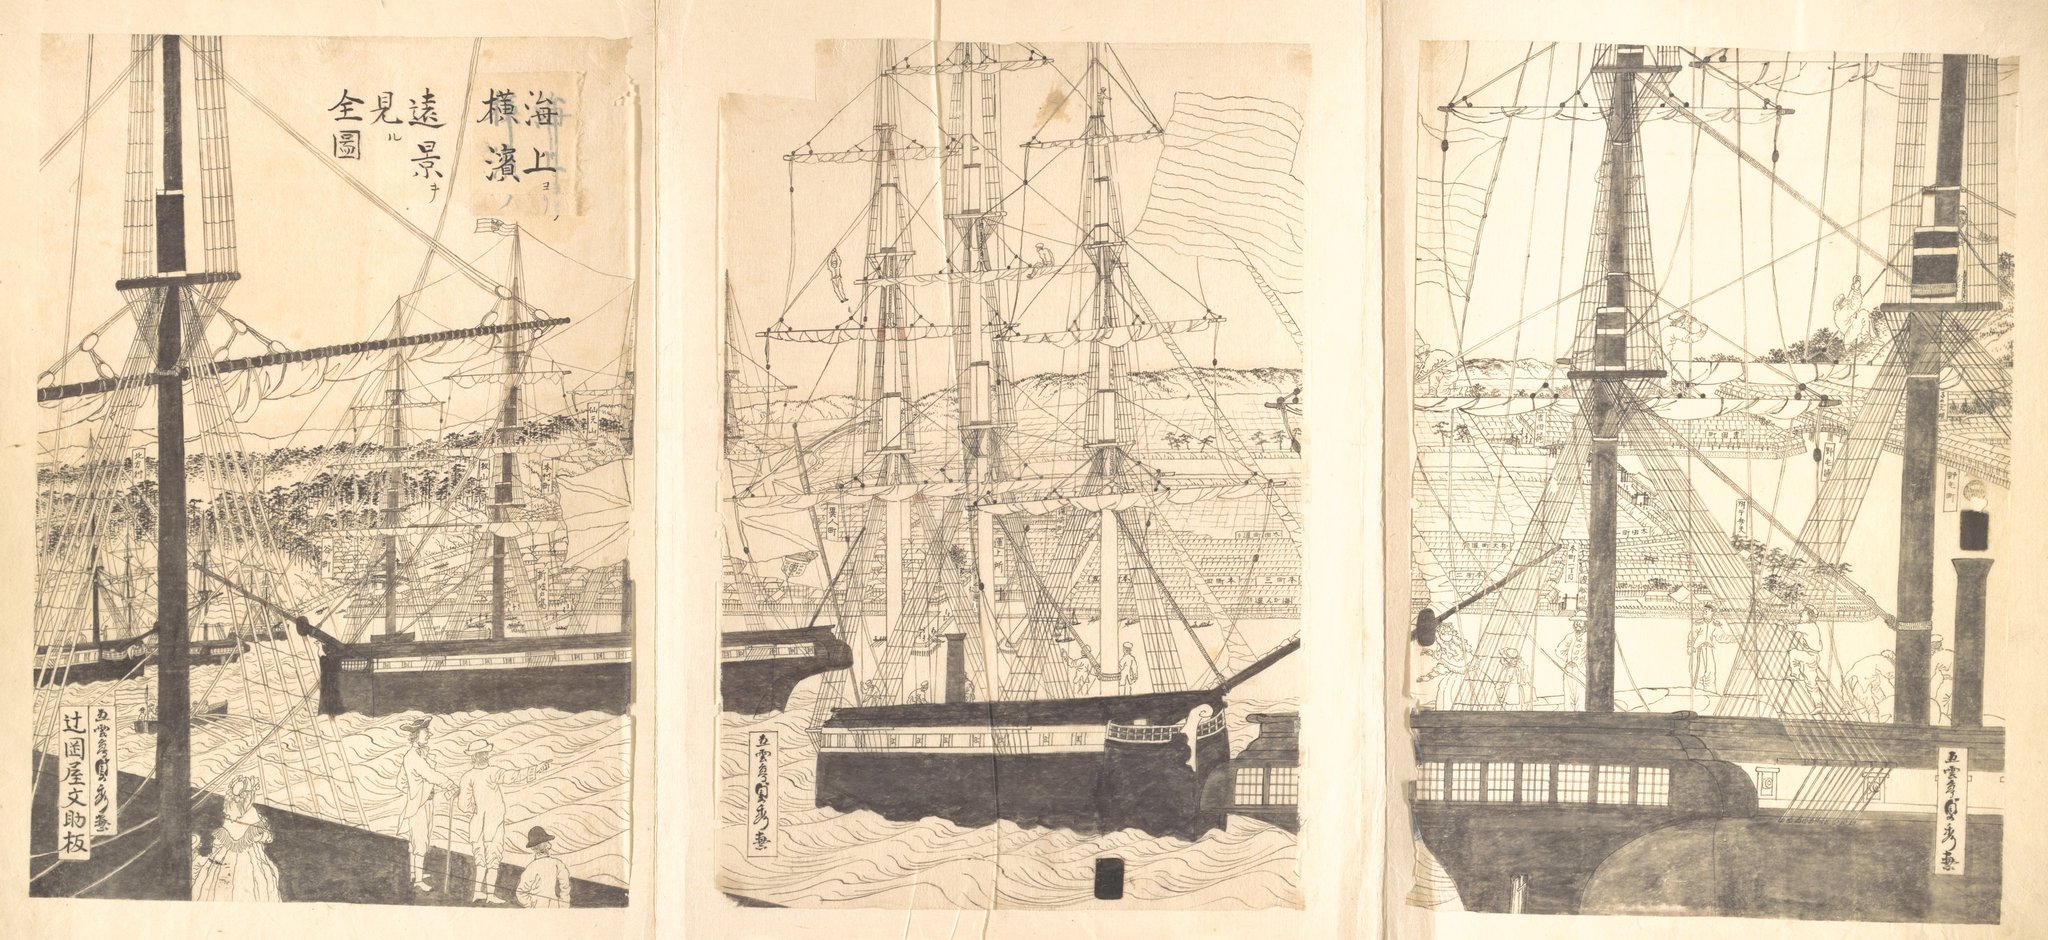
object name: print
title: Foreign Ships Offshore at Yokohama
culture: japanese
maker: utagawa (gountei) sadahide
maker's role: artist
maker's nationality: japanese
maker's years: 1807-1873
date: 1801-1900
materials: ink, paper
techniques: drawing, woodblock print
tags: men,women,waves,ships